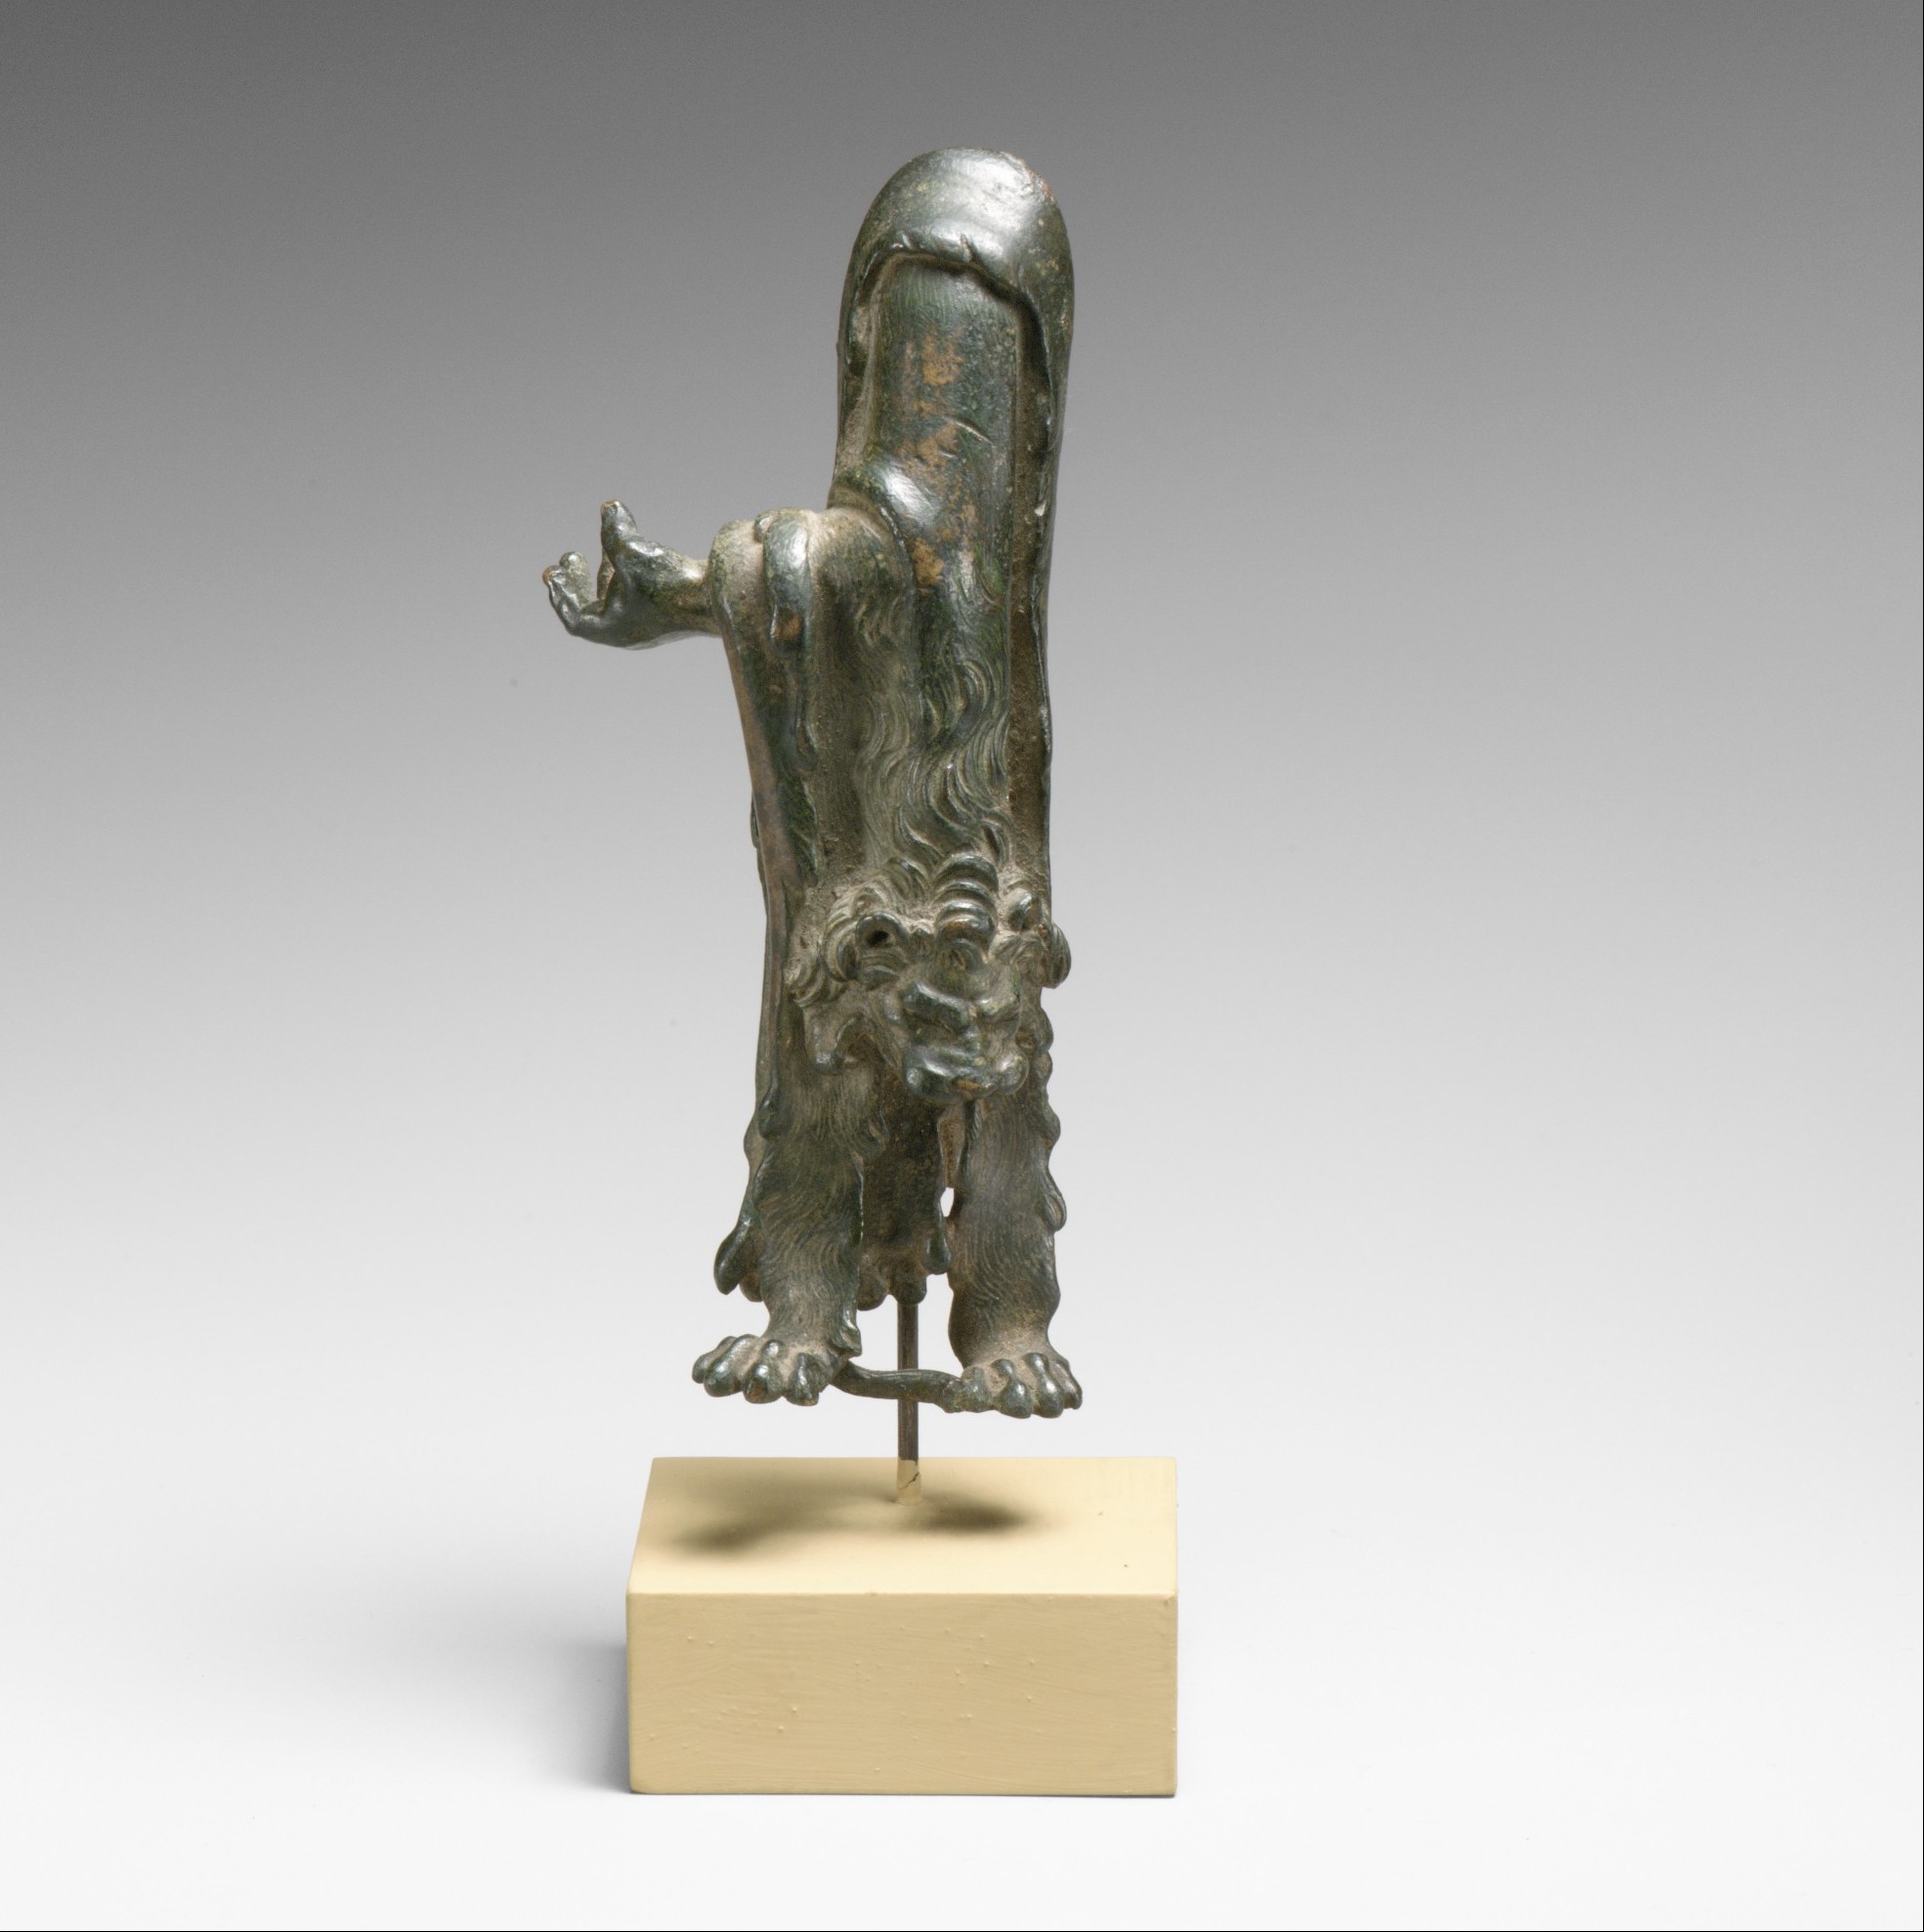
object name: statuette of herakles, fragment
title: Fragmentary bronze statuette of Herakles with lion's skin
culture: roman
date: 1-300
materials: bronze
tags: lions,herakles